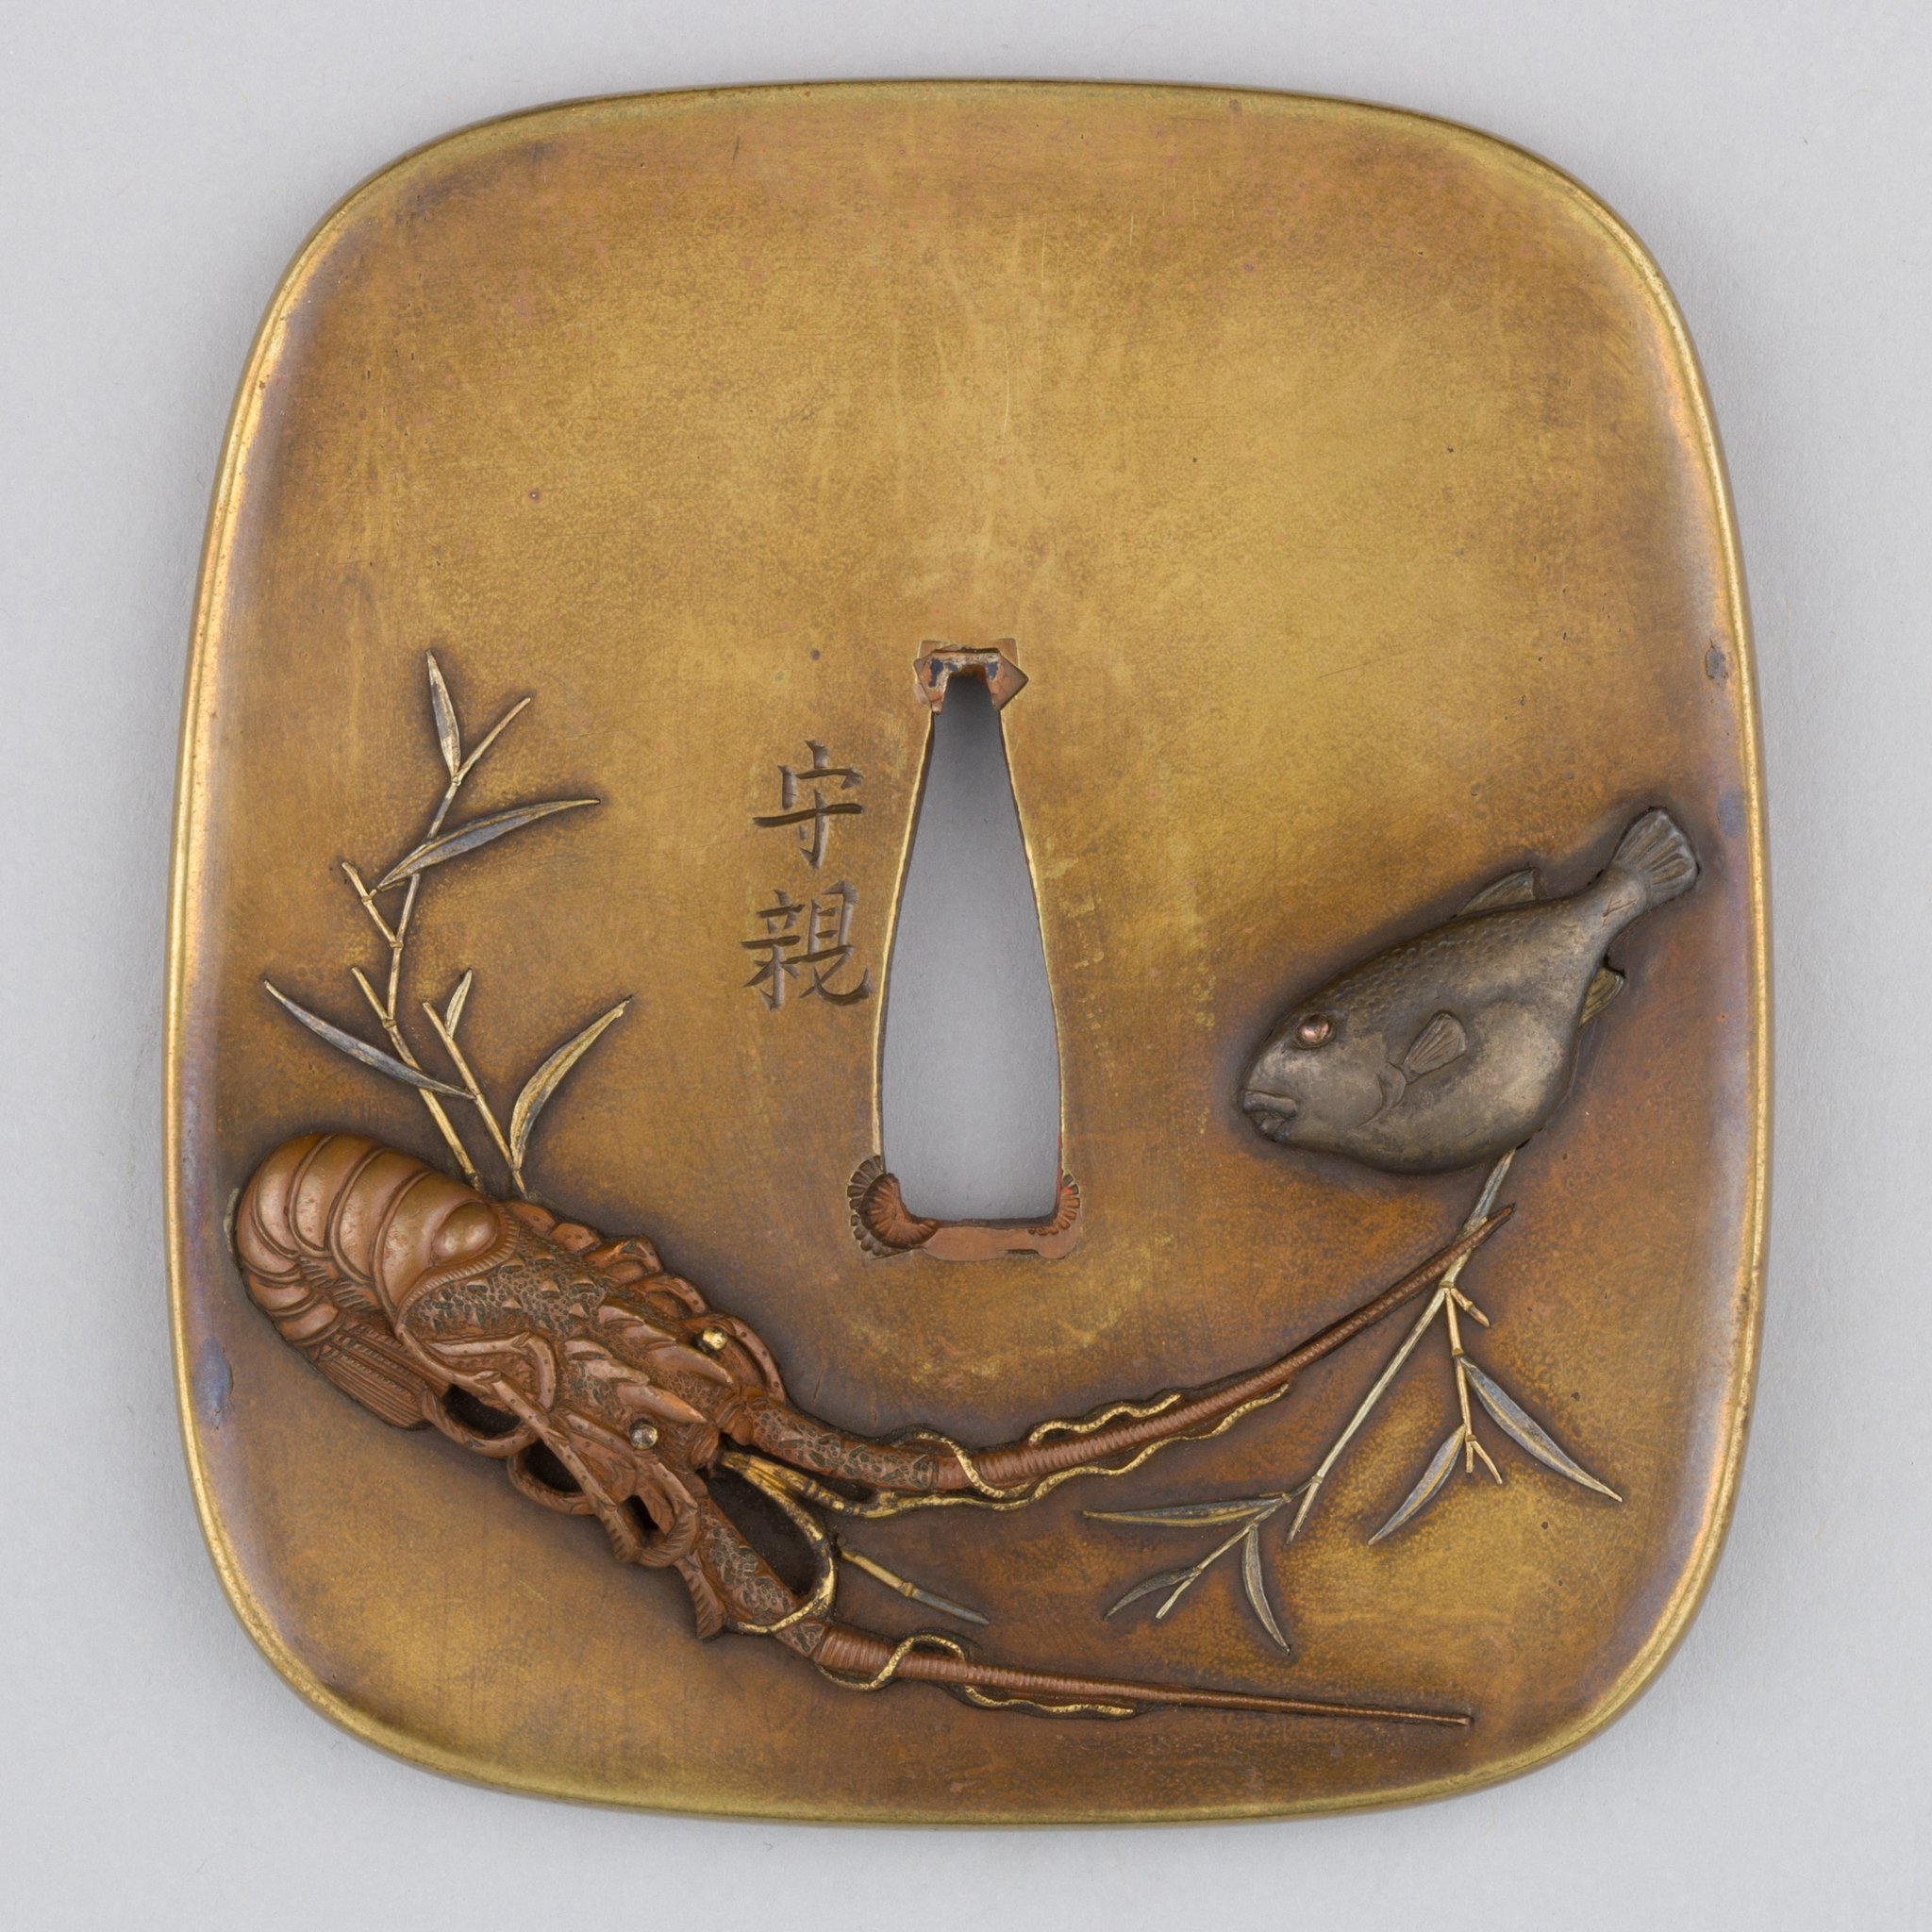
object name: sword guard tsuba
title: Sword Guard (Tsuba)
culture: japanese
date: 1615-1868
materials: copper, copper alloy, gold, silver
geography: japan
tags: fish,lobsters